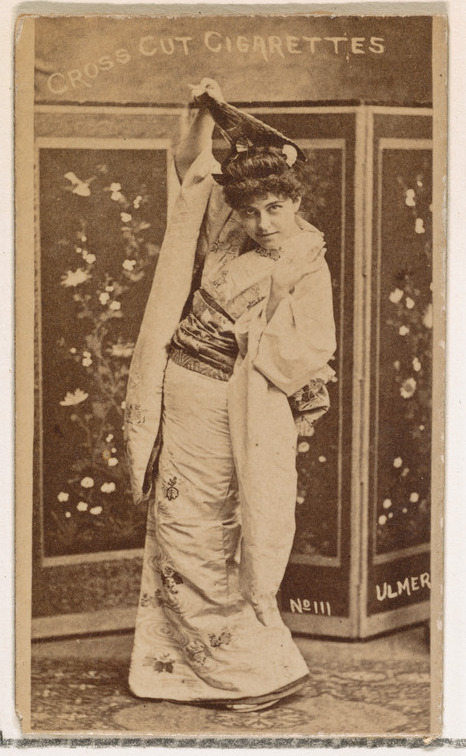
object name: print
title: Card Number 111, Geraldine Ulmer, from the Actors and Actresses series (N145-1) issued by Duke Sons & Co. to promote Cross Cut Cigarettes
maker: w. duke, sons & co.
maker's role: publisher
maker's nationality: american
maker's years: 1870-1920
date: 1880-1889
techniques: albumen silver print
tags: portraits,women,actresses